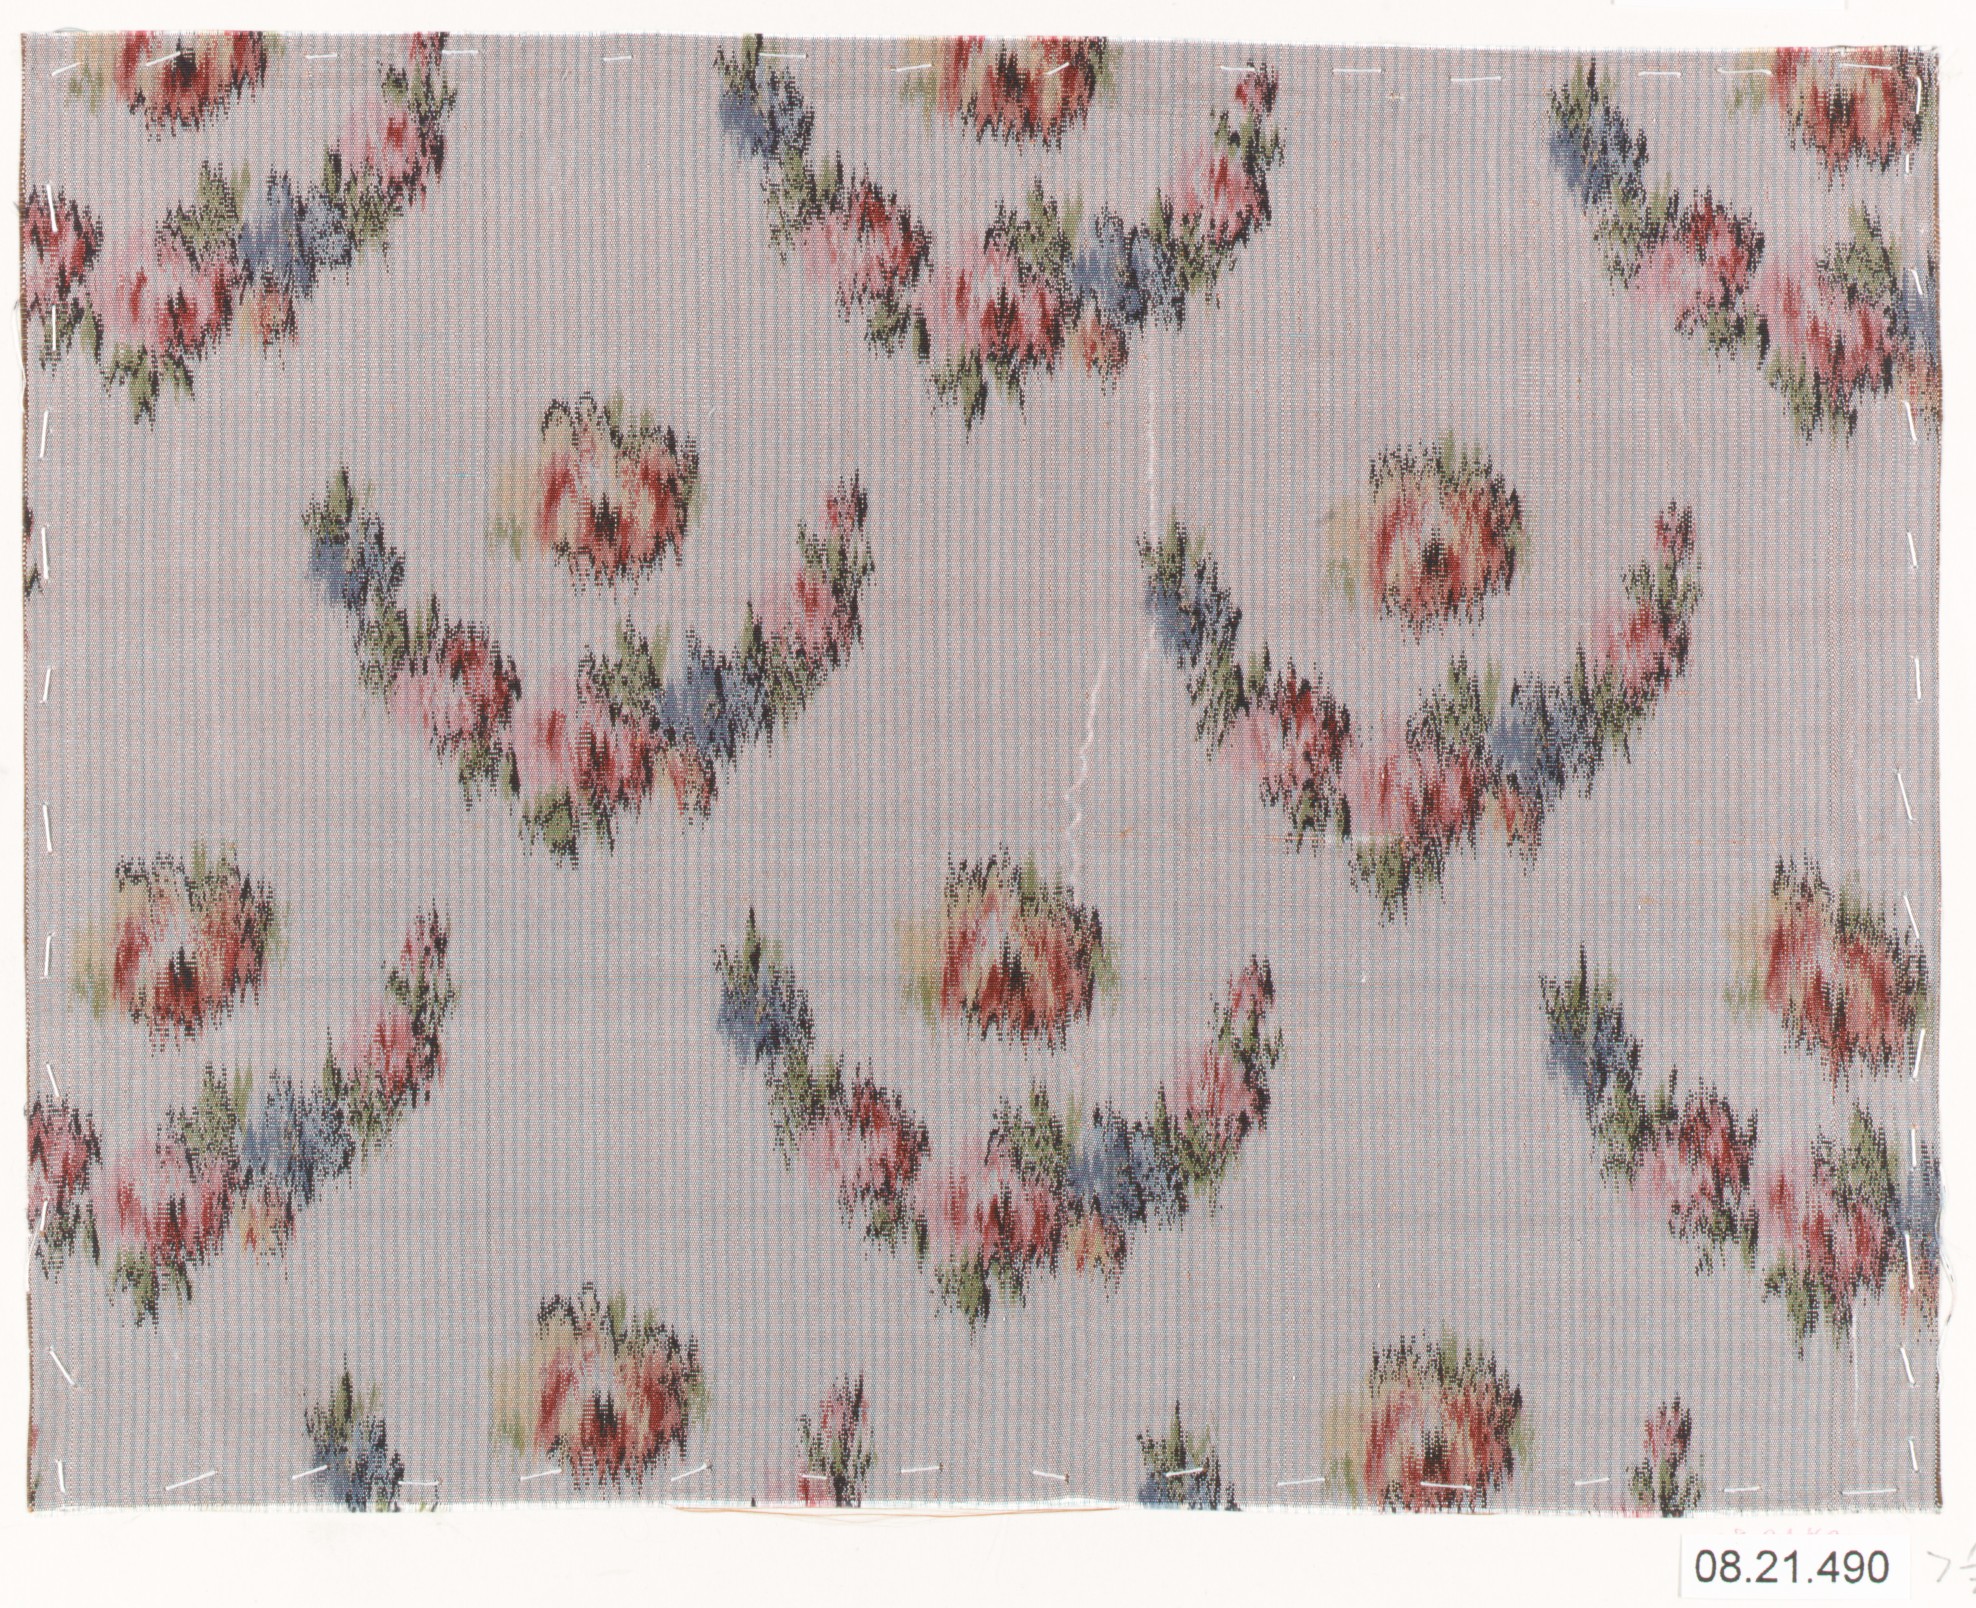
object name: textile sample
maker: Anonymous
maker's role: designer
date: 1900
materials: silk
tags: flowers